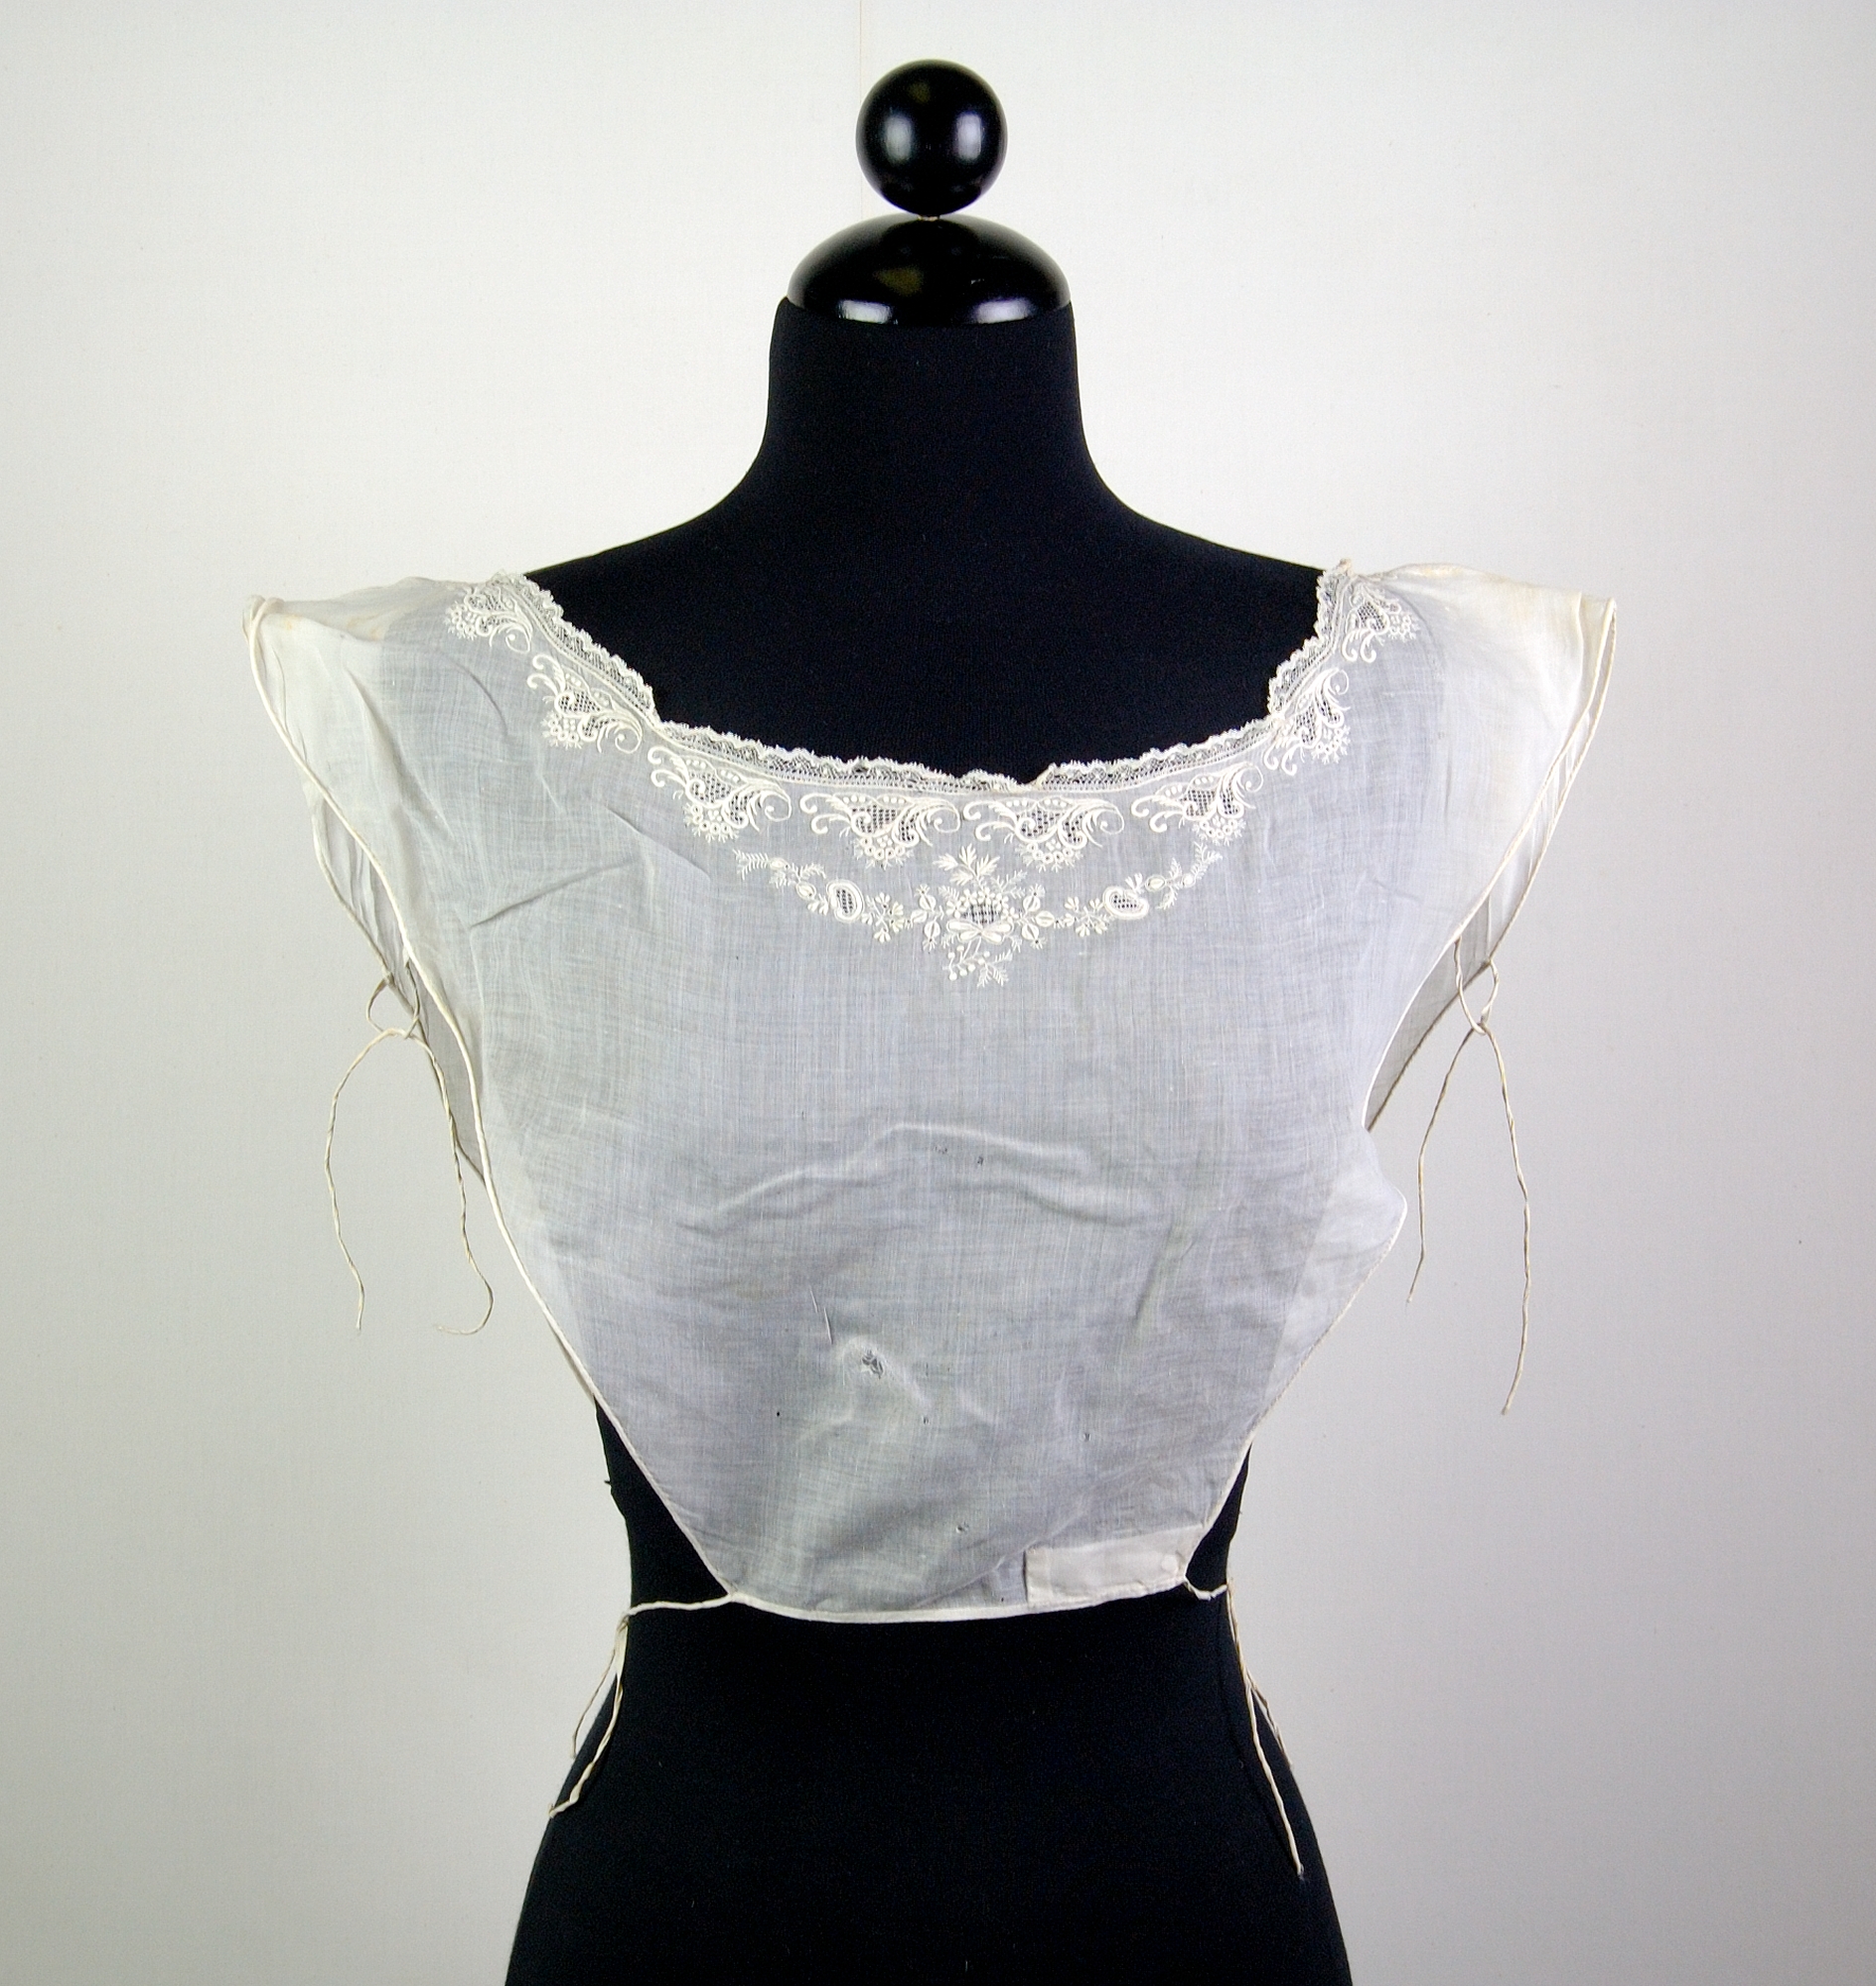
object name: chemise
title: Chemisette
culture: scottish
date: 1845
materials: cotton